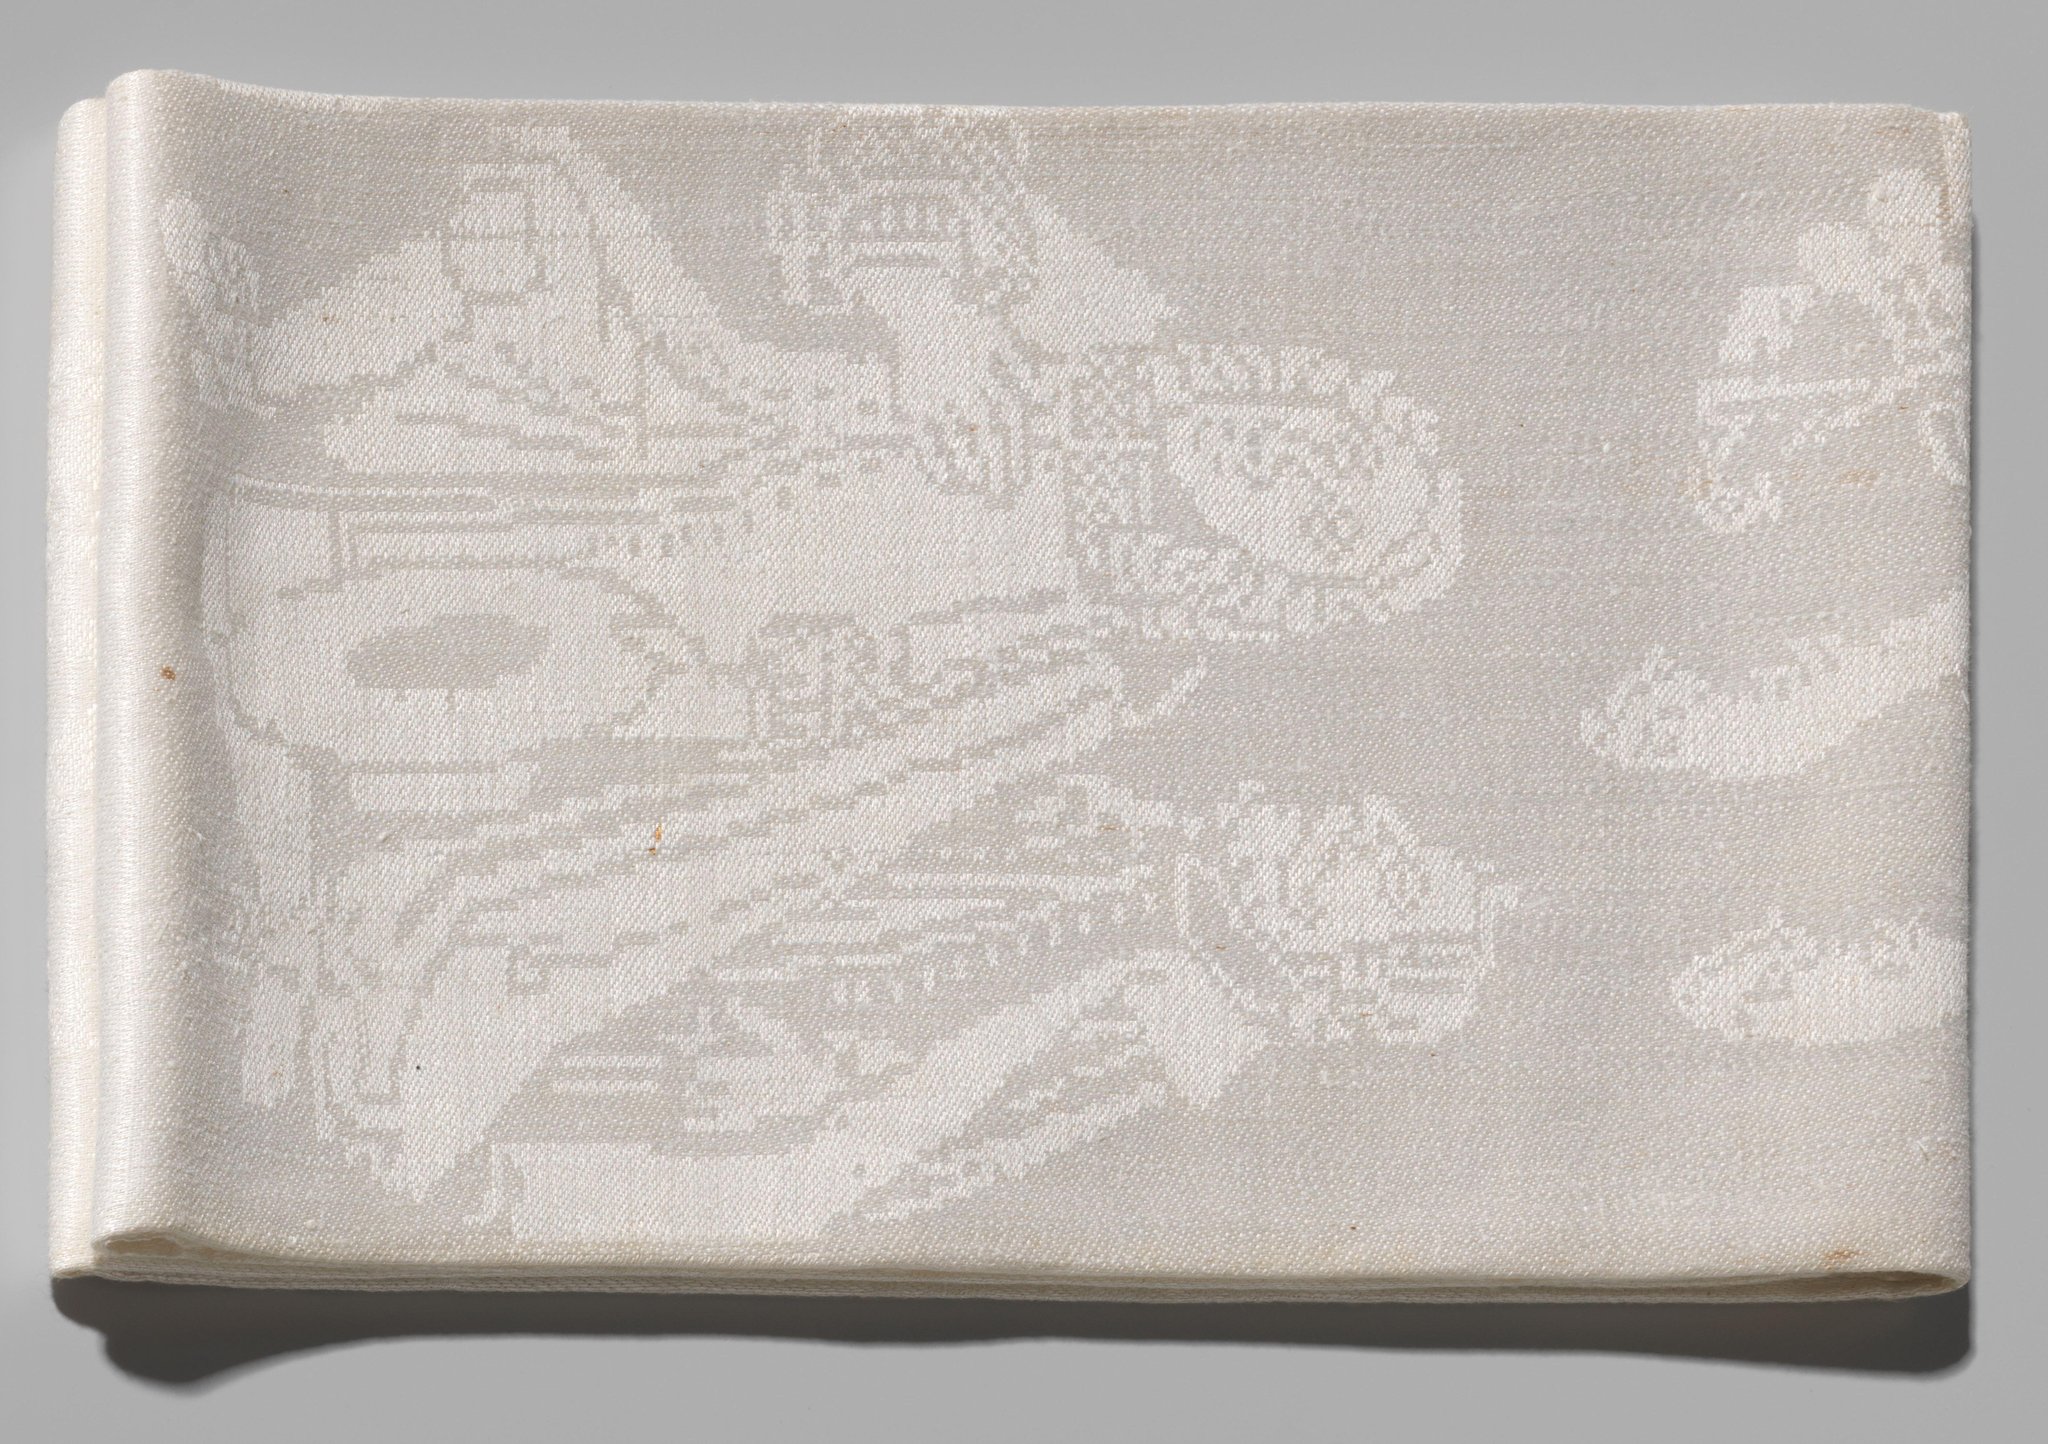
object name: napkin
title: Servet op het ontzet van Grave door stadhouder Willem III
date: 1674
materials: linen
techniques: damask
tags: the hague, william iii (prince of orange and king of england, scotland, and ireland), grave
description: Servet van linnendamast op het ontzet van Grave door stadhouder Willem III. Middenveld: Het symmetrisch patroon vertoont van onder naar boven de volgende taferelen: 1 De vesting Grave aan een rivier. Opschriften: DE MAES, D'GRAEF en DE BORGHERS VAN GRAEF DANCKEN SYN HOOGHEYT VAN HUN VERLOSSINGHE. 2 Drie burgers met de hoed in de hand en twee knielend, gekleed in justaucorps, kniebroek, cape en platte pruiken. 3 Kasteel, met ter weerszijden een steigerend omziend paard, waarop ruiter, gekleed in justaucorps met brede manchetten, sjerp, lange pruik, gevederde breedgerande hoed en dragende een maarschalkstaf. Boven zijn hoofd een engel met lauwerkrans en bazuin. 4 Gekroond wapenschild van Willem III, omgeven door de leuze van de orde van de kousenband HONI SOIT QUI MAL I PENCE. In het midden het jaartal 1674 en LANGE LEEFT ONSEN VICTORIUESEN PRINCE VAN ORANGE. Staande randen: enkelvoudige lopende rank met anjer, eikel, tulp, viooltje, kersen, granaatappel, narcis en druiventros. Rondom: blokkenrand.